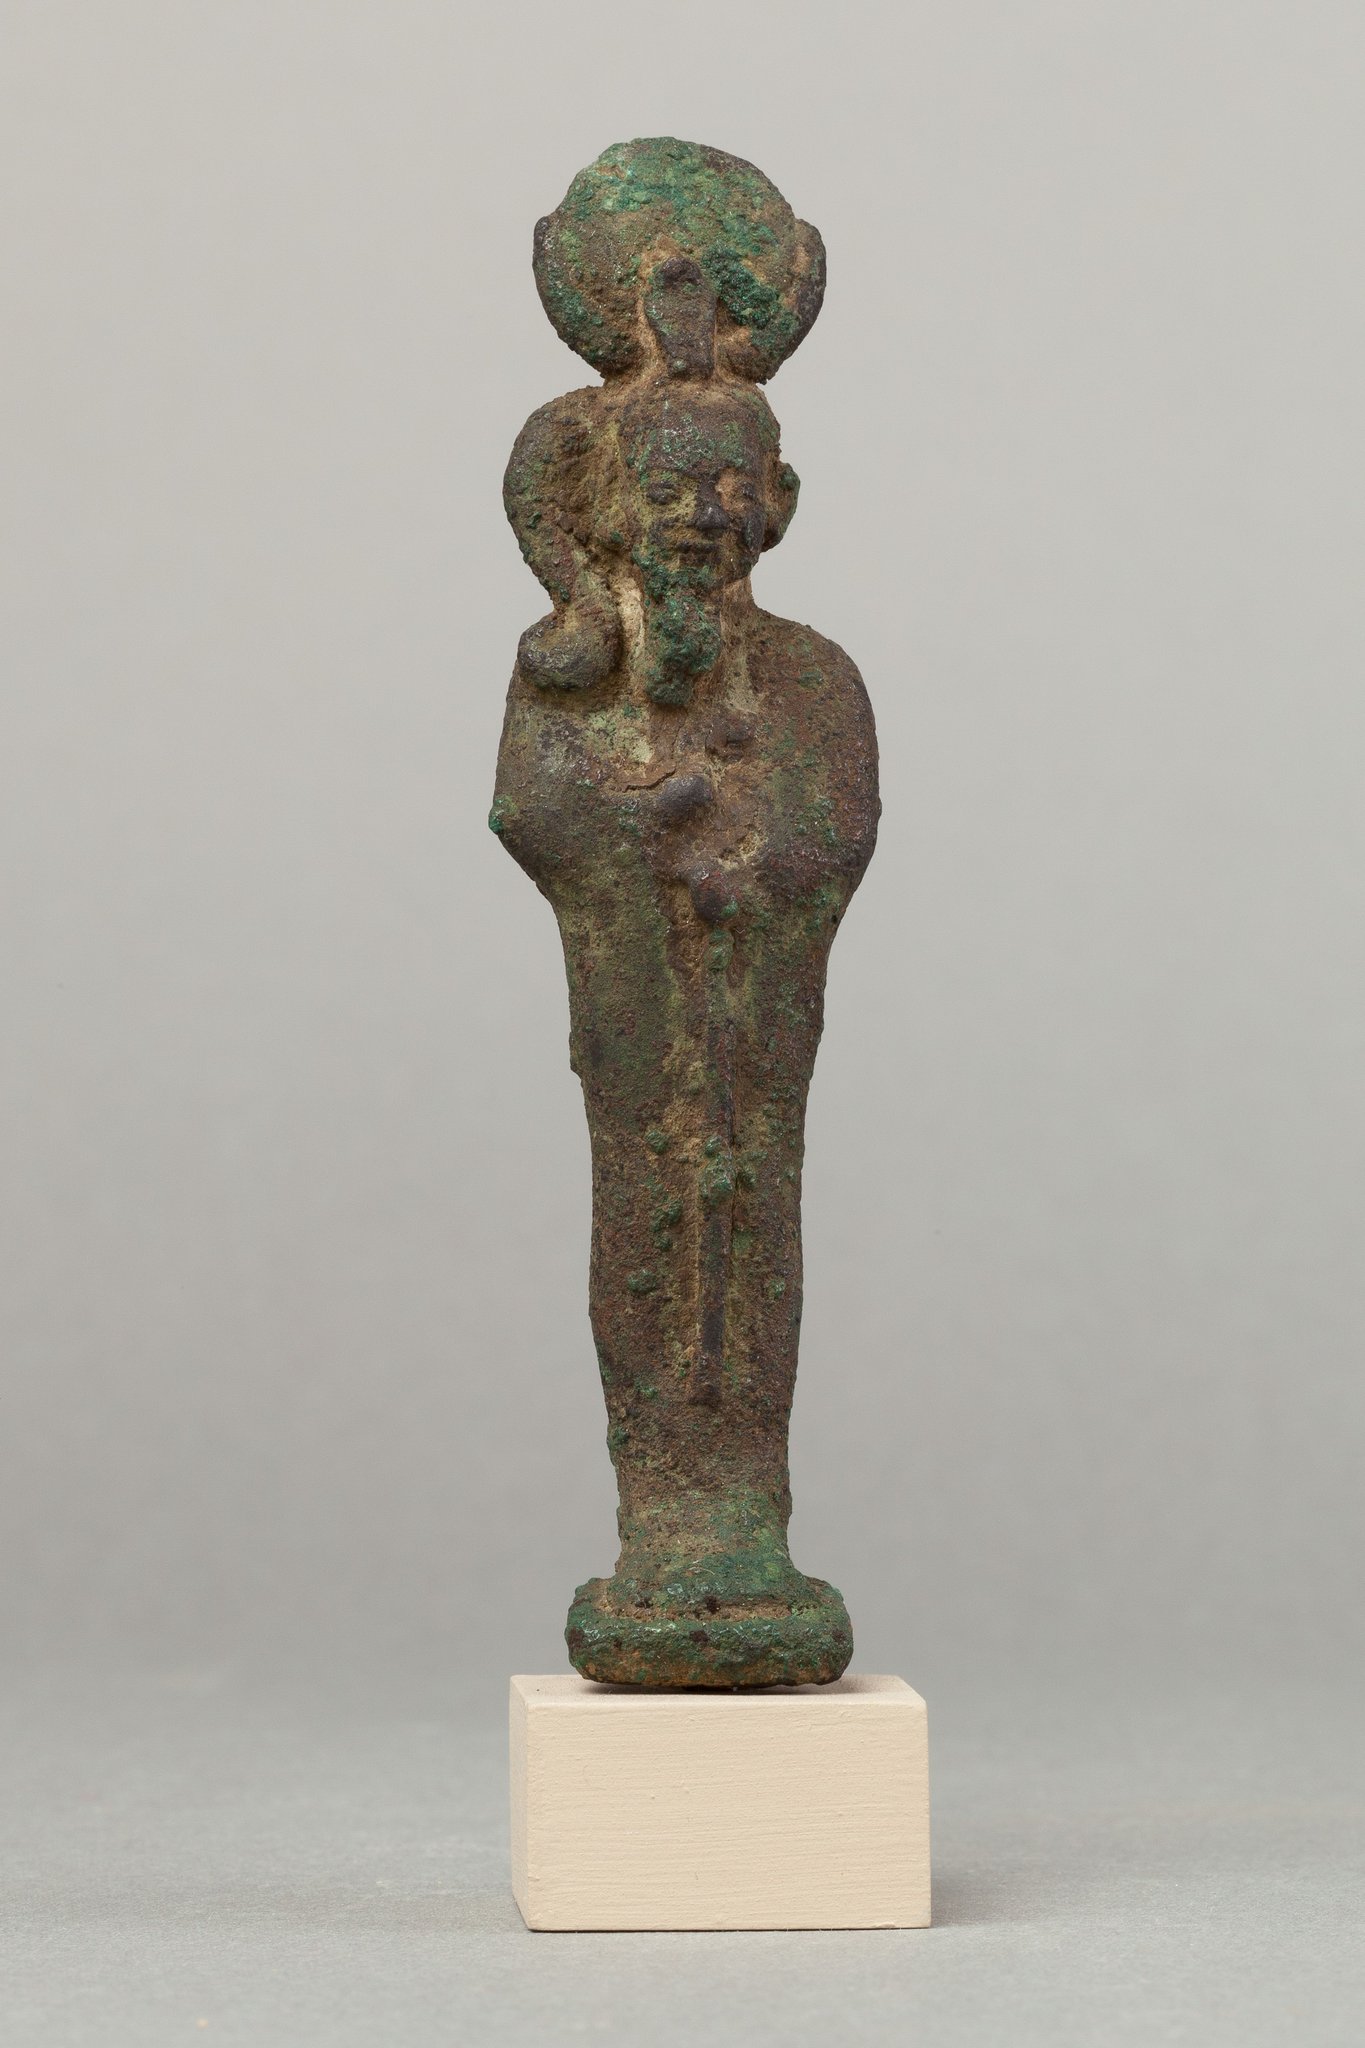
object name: statuette, khonsu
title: Khonsu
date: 664-630 BCE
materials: metal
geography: egypt